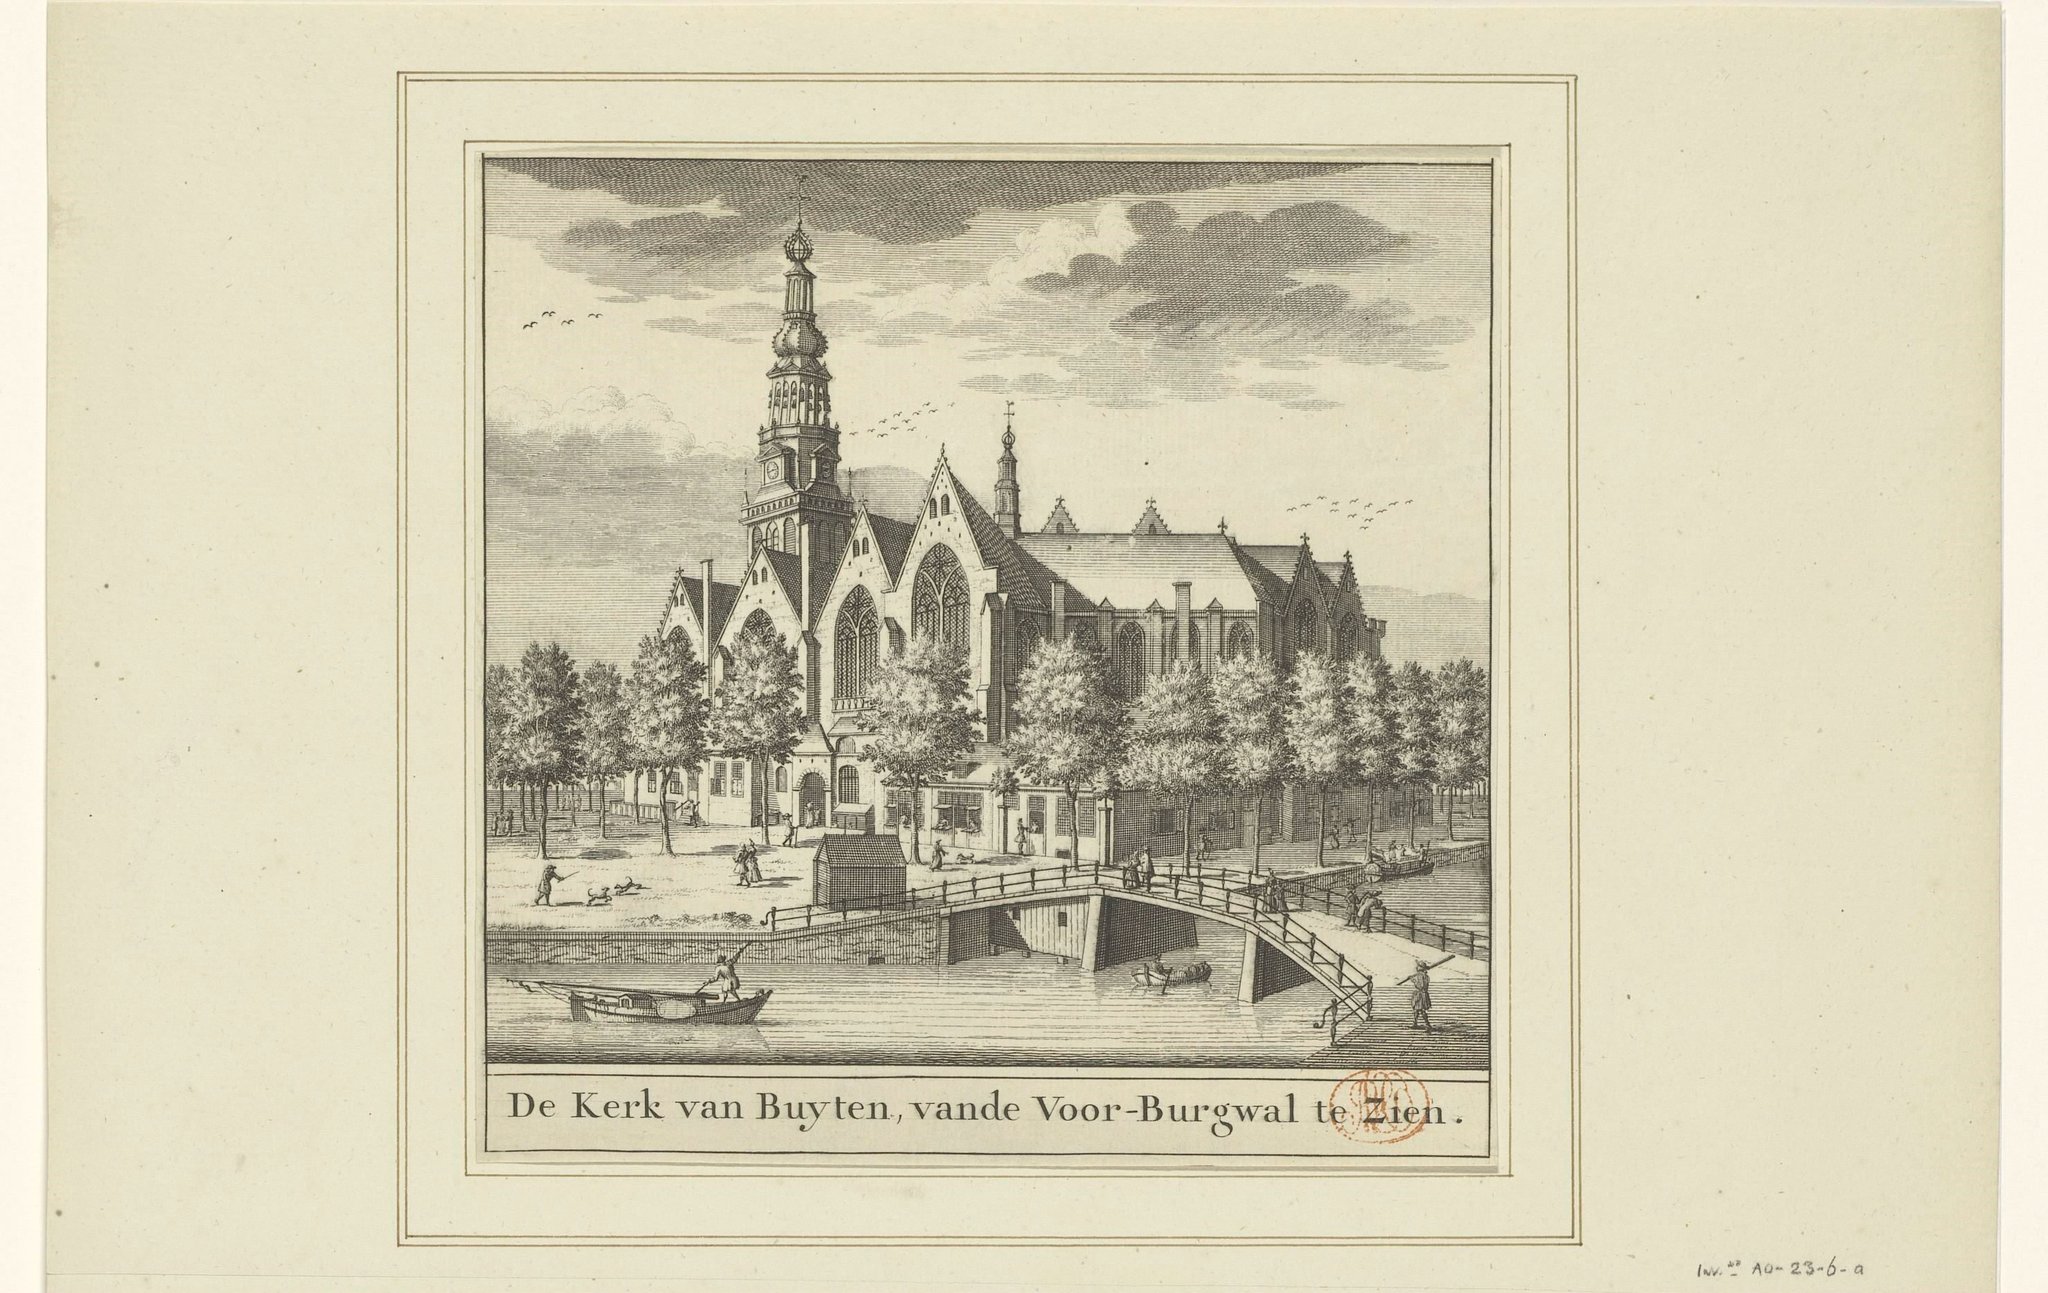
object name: print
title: De Kerk van Buyten, vande Voor-Burgwal te Zien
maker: daniël stopendaal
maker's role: print maker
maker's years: 1672-1726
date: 1685-1726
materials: paper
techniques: engraving, etching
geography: amsterdam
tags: bridge in city across river, canal, etc. (+ city(-scape) with figures, staffage), church (exterior)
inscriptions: collector's mark: Lugt 195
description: Is waarschijnlijk oorspronkelijk één van de randprenten van 'Caart vande Sitplaat-zen inde Oude-Kerk', een plattegrond van de zitplaatsen in de Oude Kerk. Daniël Stopendaal staat als prentmaker vermeld op de plattegrond zelf, de randprenten zijn mogelijk ook door hem gemaakt. Zie RP-P-AO-23-6-2, RP-P-AO-23-7 en RP-P-AO-23-8 voor andere bijhorende randprenten. Zie RP-P-AO-23-57 voor een soortgelijke plattegrond van de Oosterkerk met randprenten.